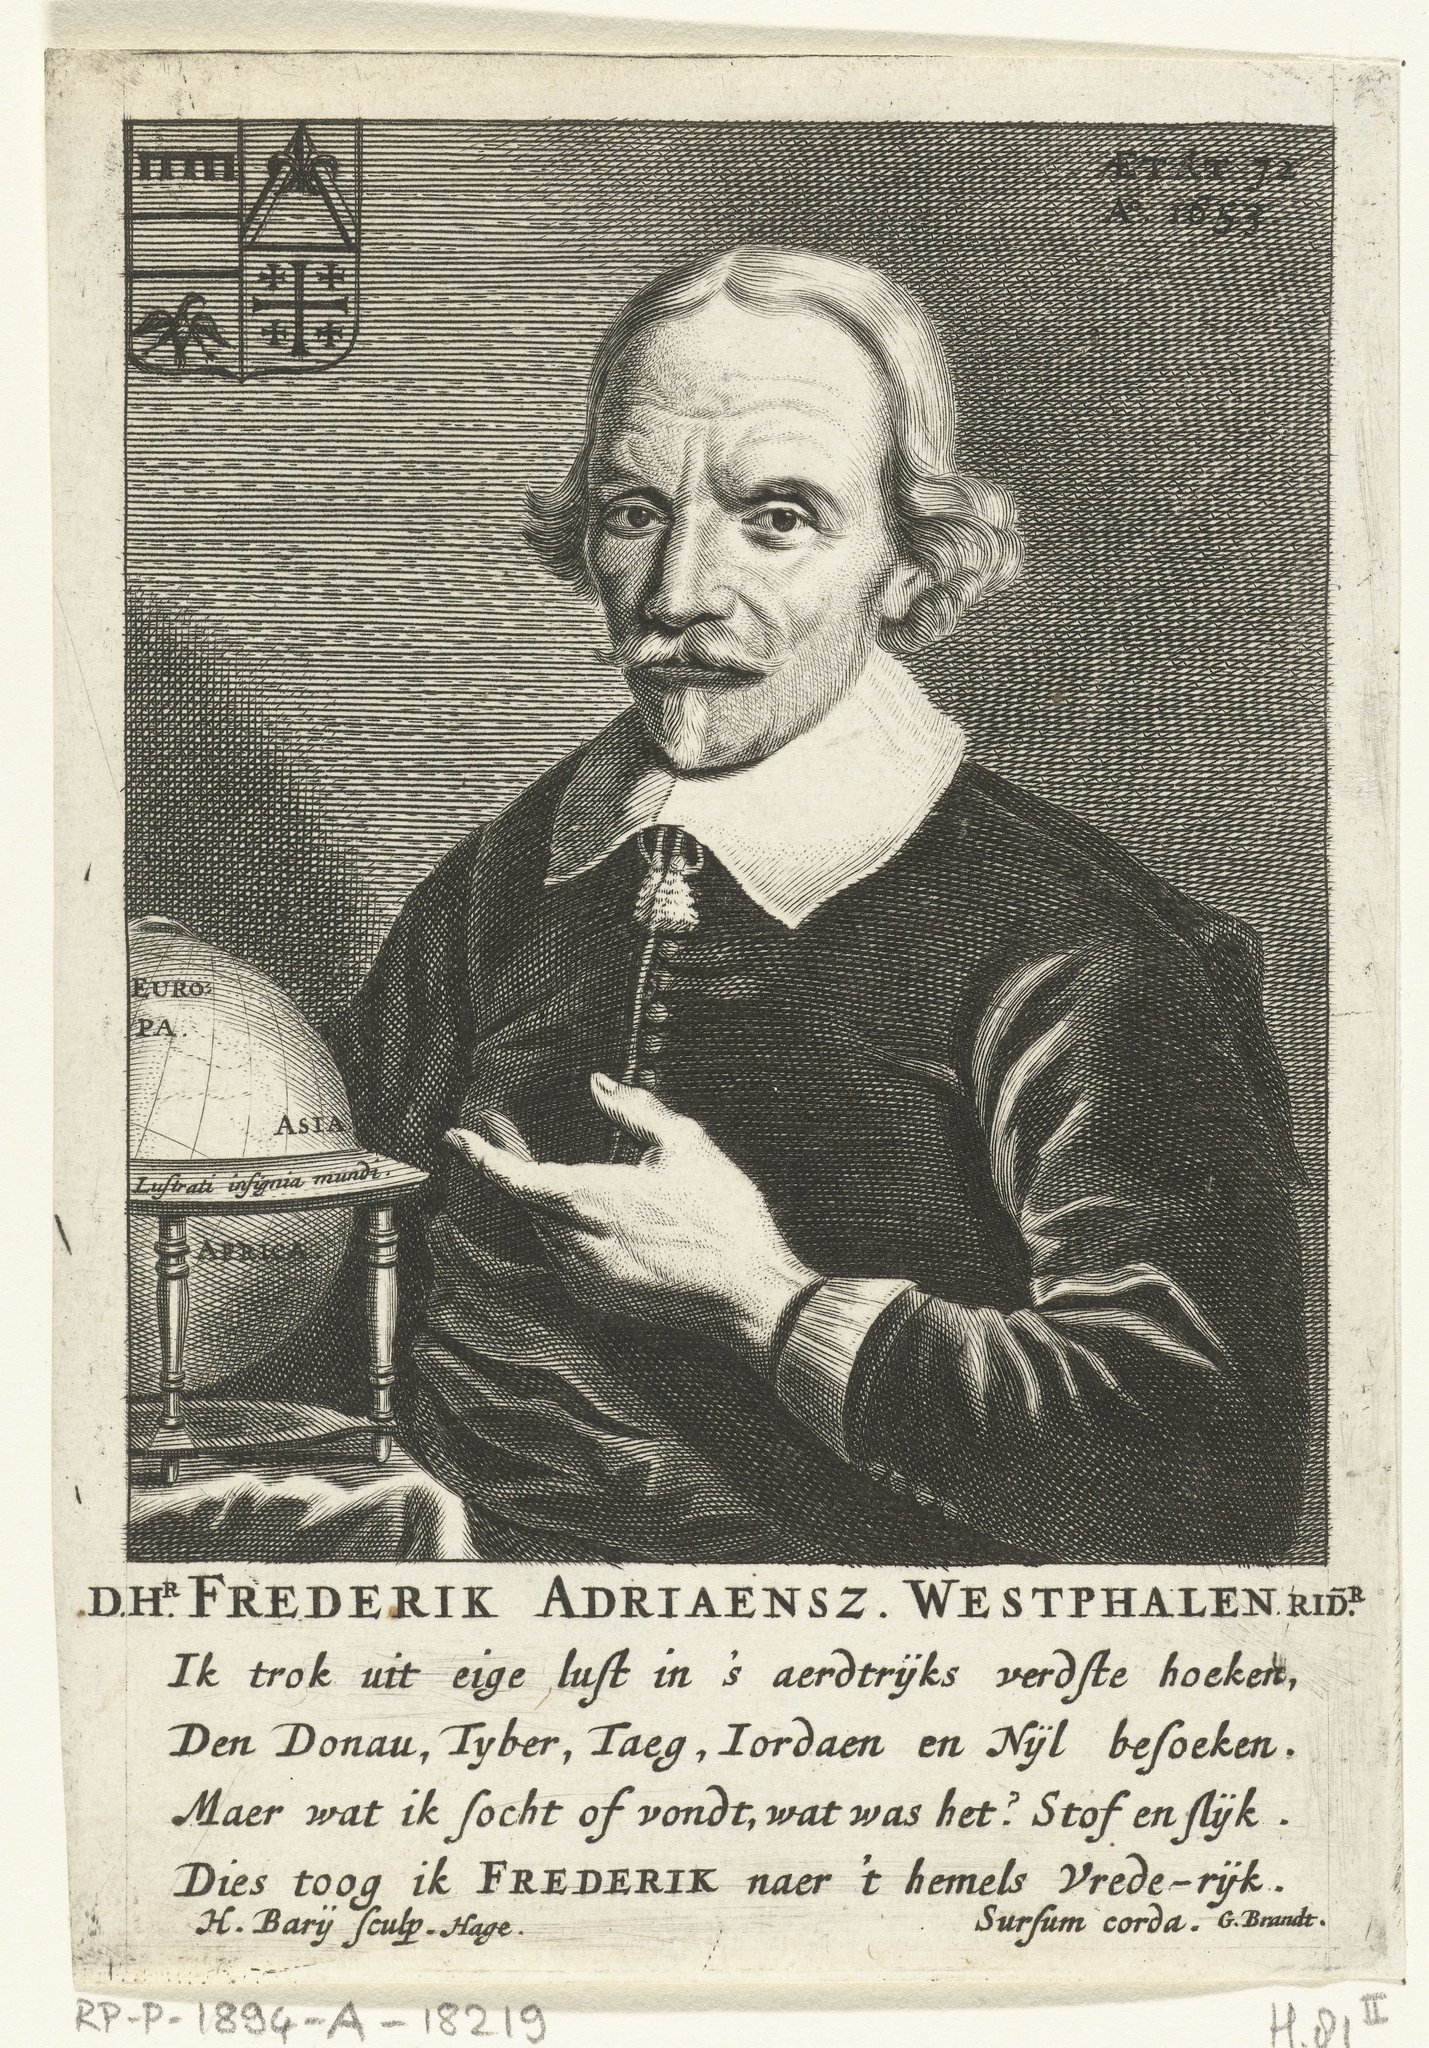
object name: print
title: Portret van Frederik Adriaensz. Westphalen op 72-jarige leeftijd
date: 1657-1707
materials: paper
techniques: engraving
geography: netherlands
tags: enkhuizen, traveler, globe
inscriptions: collector's mark: Lugt 2228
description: Portret van Frederik Adriaensz. Westphalen op 72-jarige leeftijd, naast hem een globe. In de linker bovenhoek zijn wapen. Onder het portret een vers van vier regels in het Nederlands door G. Brandt getekend: Sursum Corda.